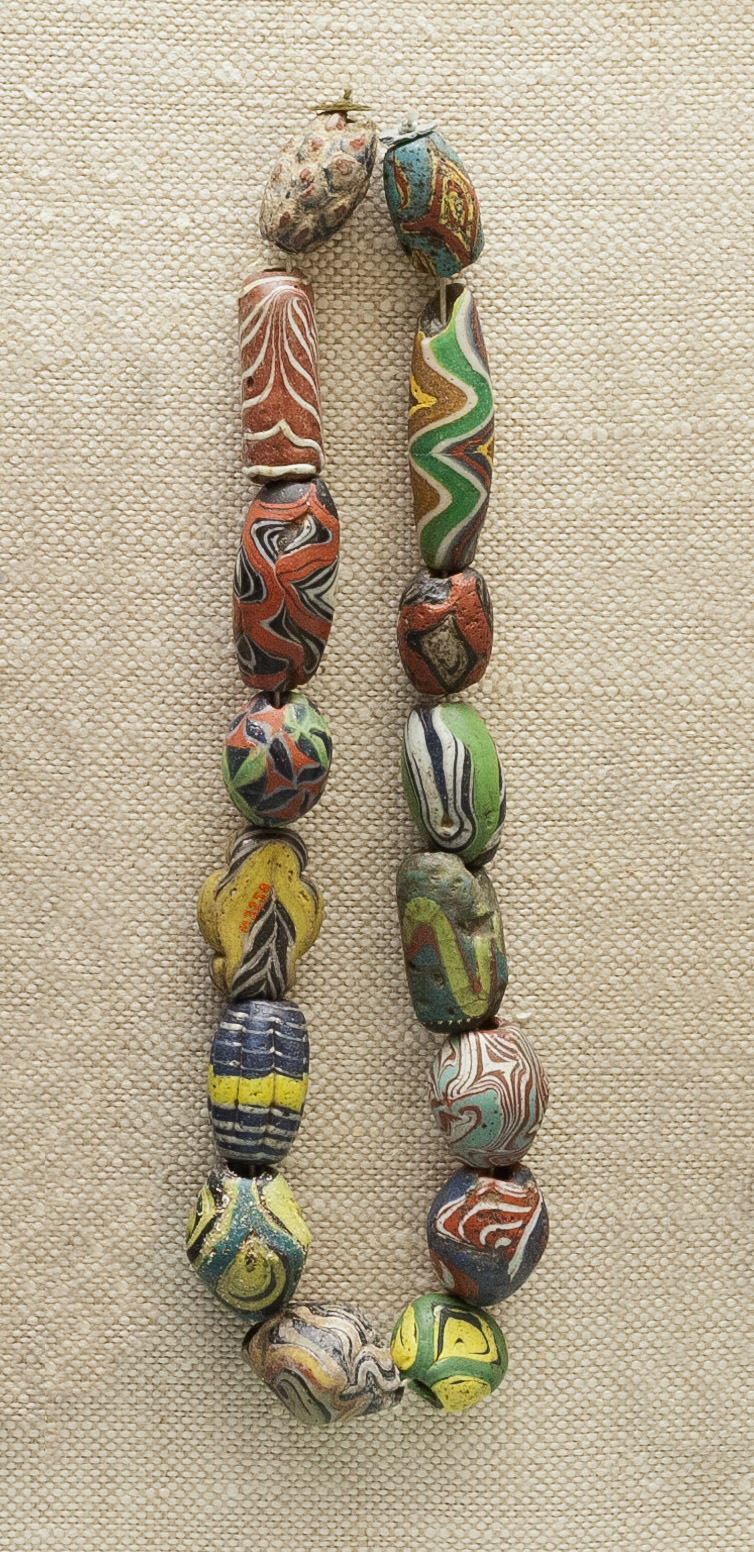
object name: bead, string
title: String of 16 beads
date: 601-1000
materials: glass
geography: egypt